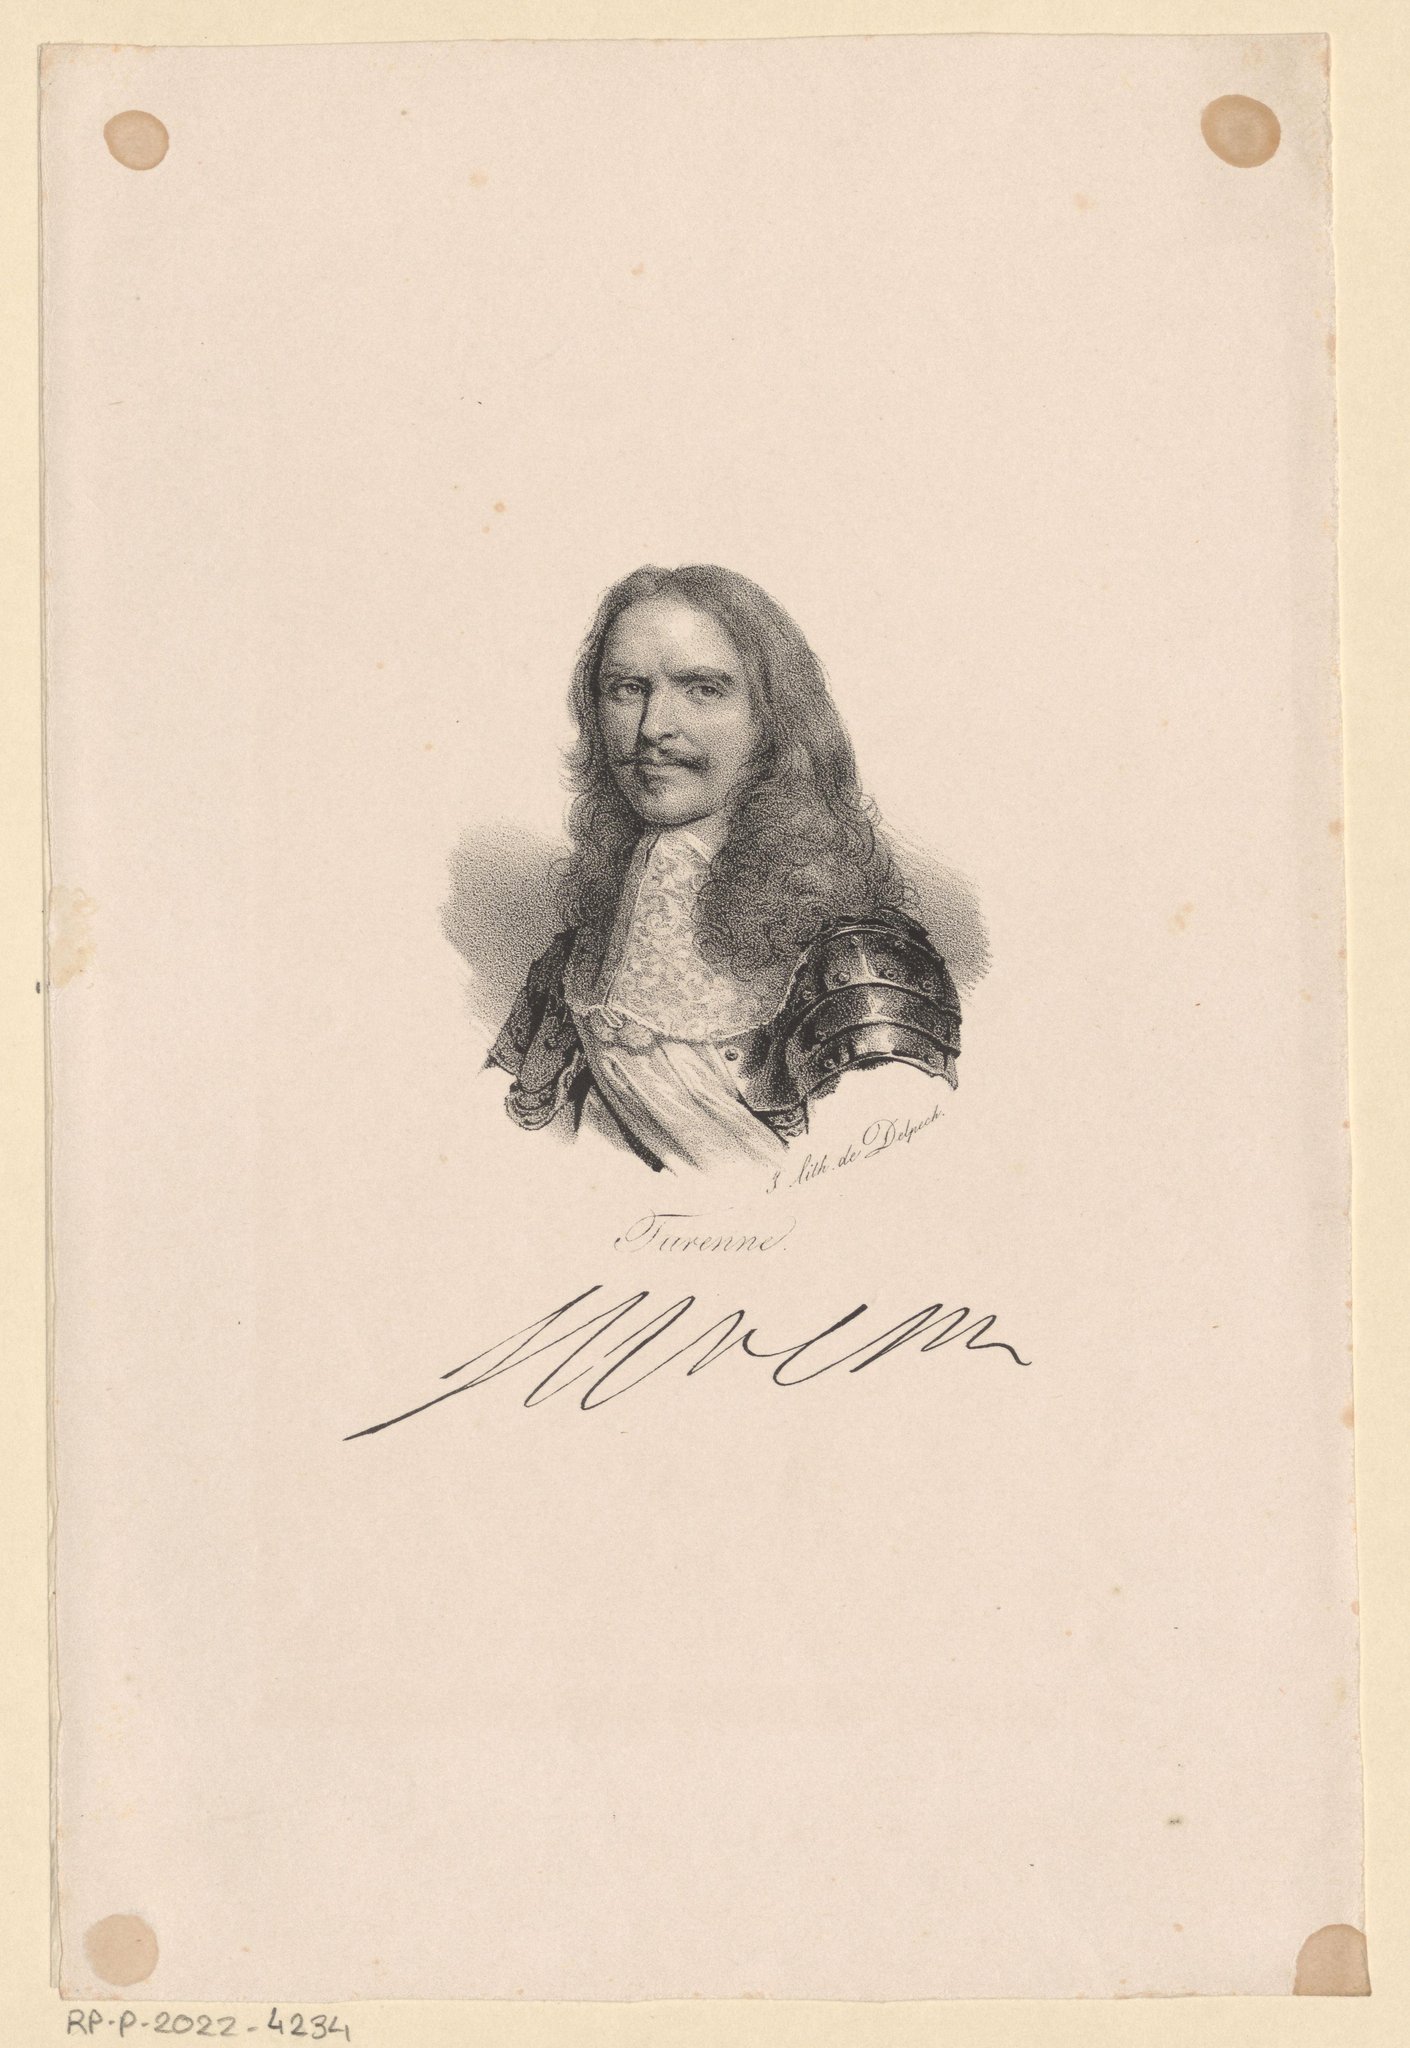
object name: print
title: Turenne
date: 1825-1842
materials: paper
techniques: lithograph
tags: commander-in-chief, general, marshal, armour, historical persons